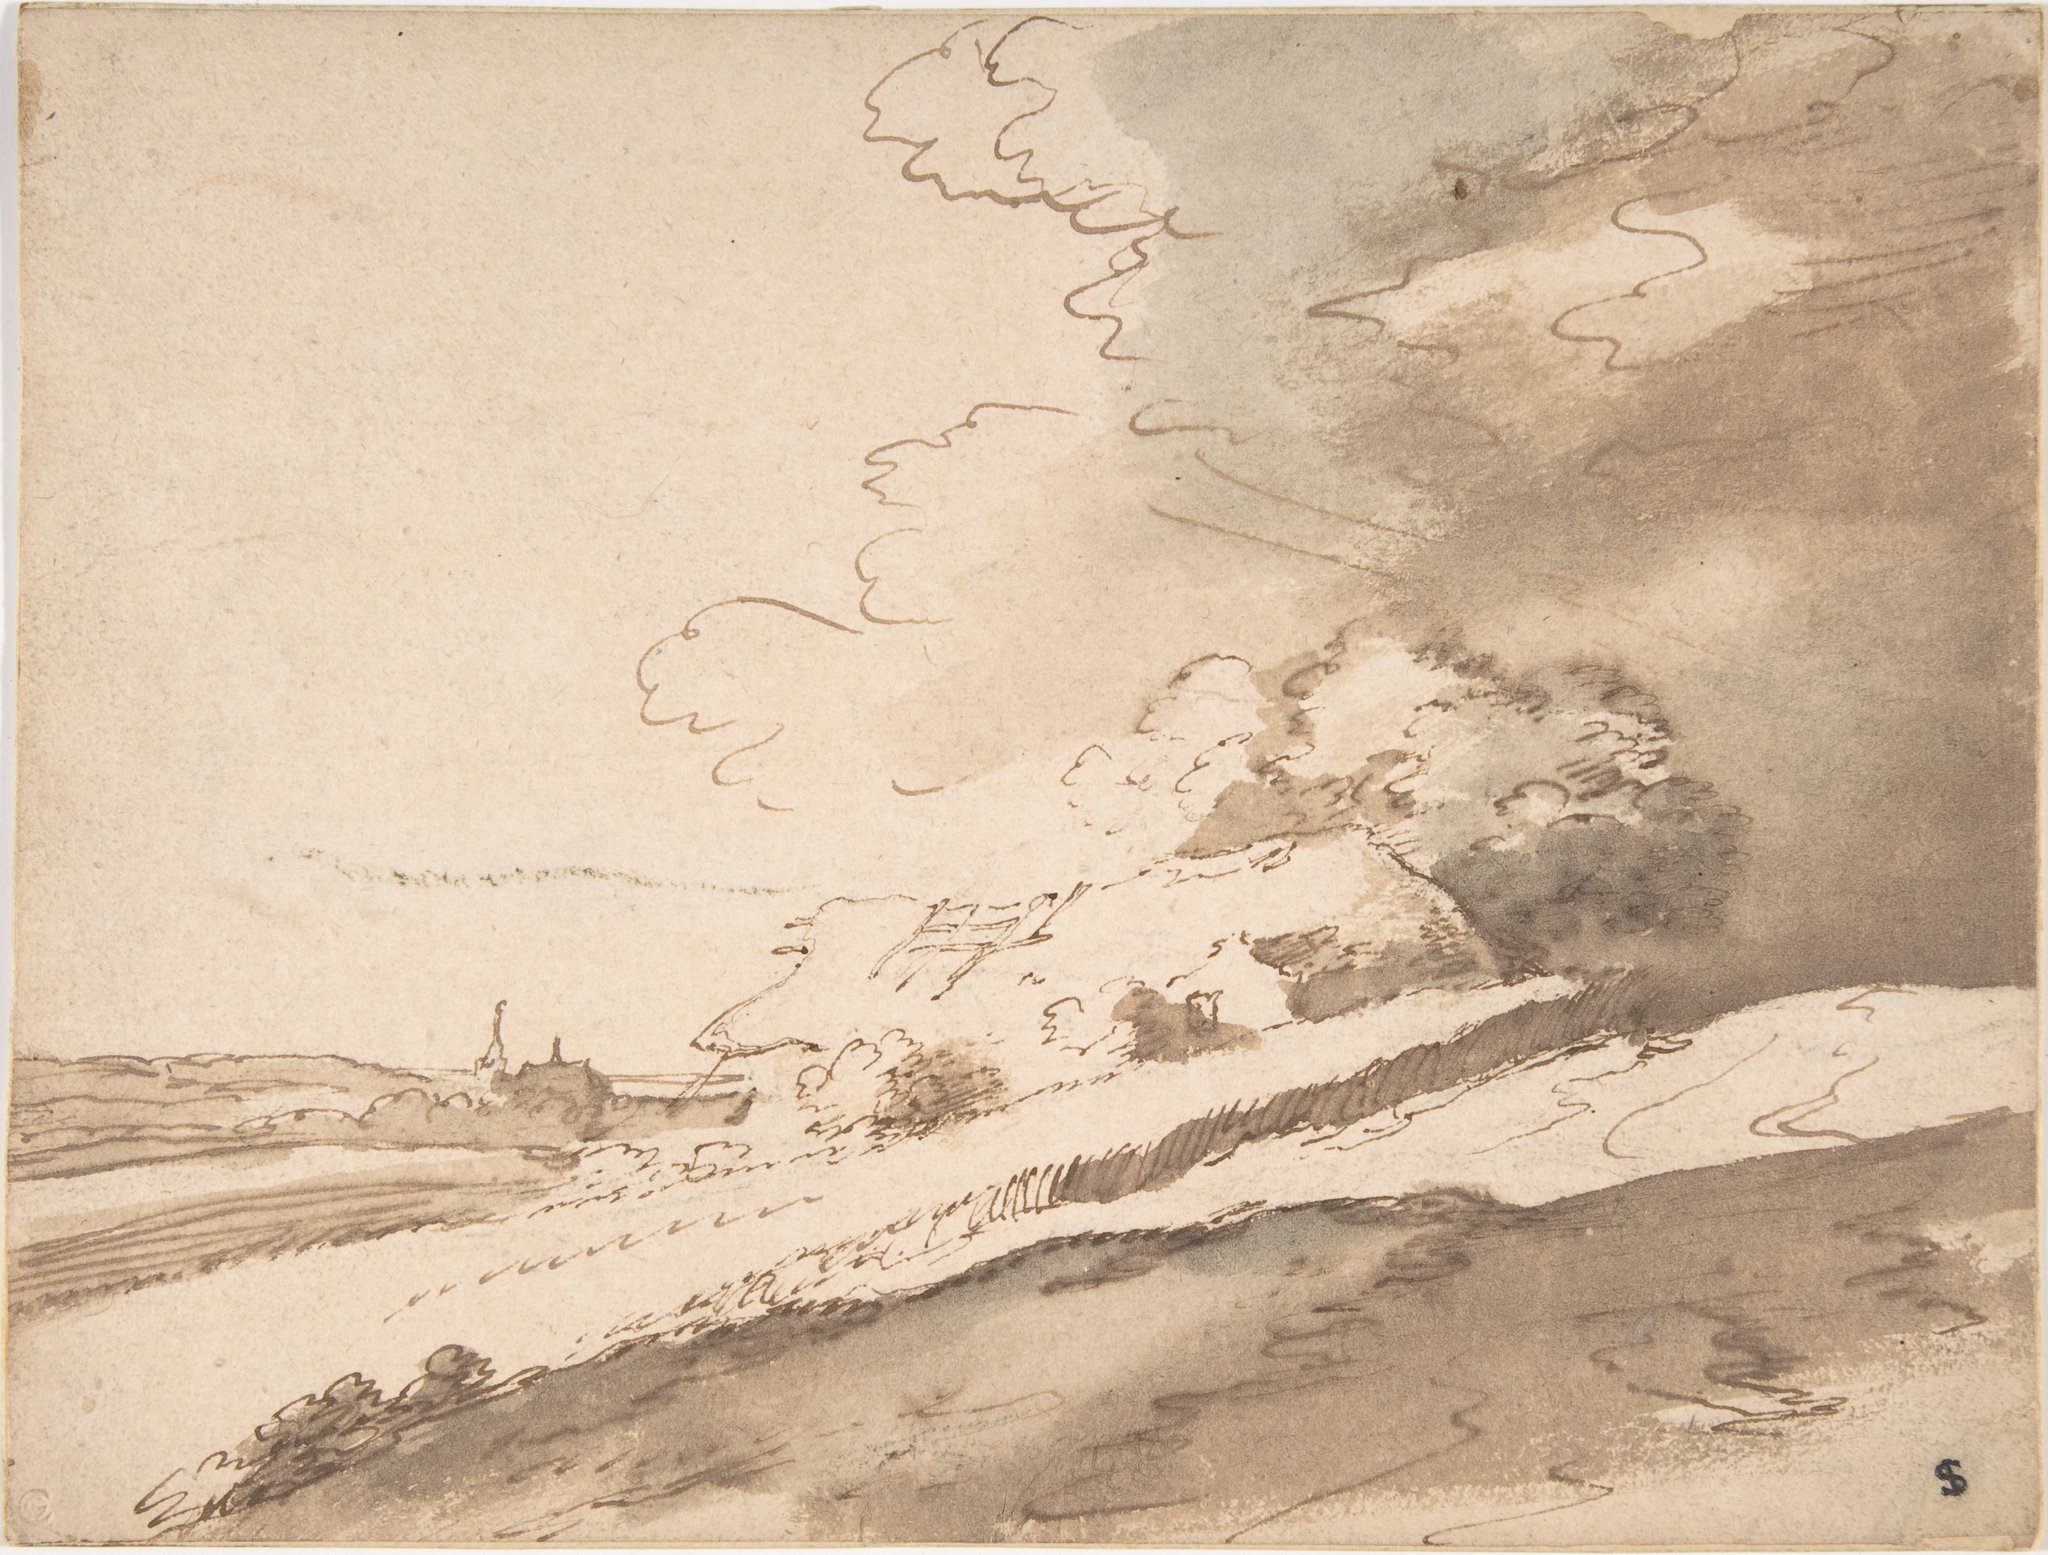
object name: drawing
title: Landscape with Farm House and a Steeple in the Distance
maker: anonymous, dutch, 17th century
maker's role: artist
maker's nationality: dutch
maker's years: 1600-1700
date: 1601-1700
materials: ink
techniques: brush, pen, wash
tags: houses,landscapes,trees